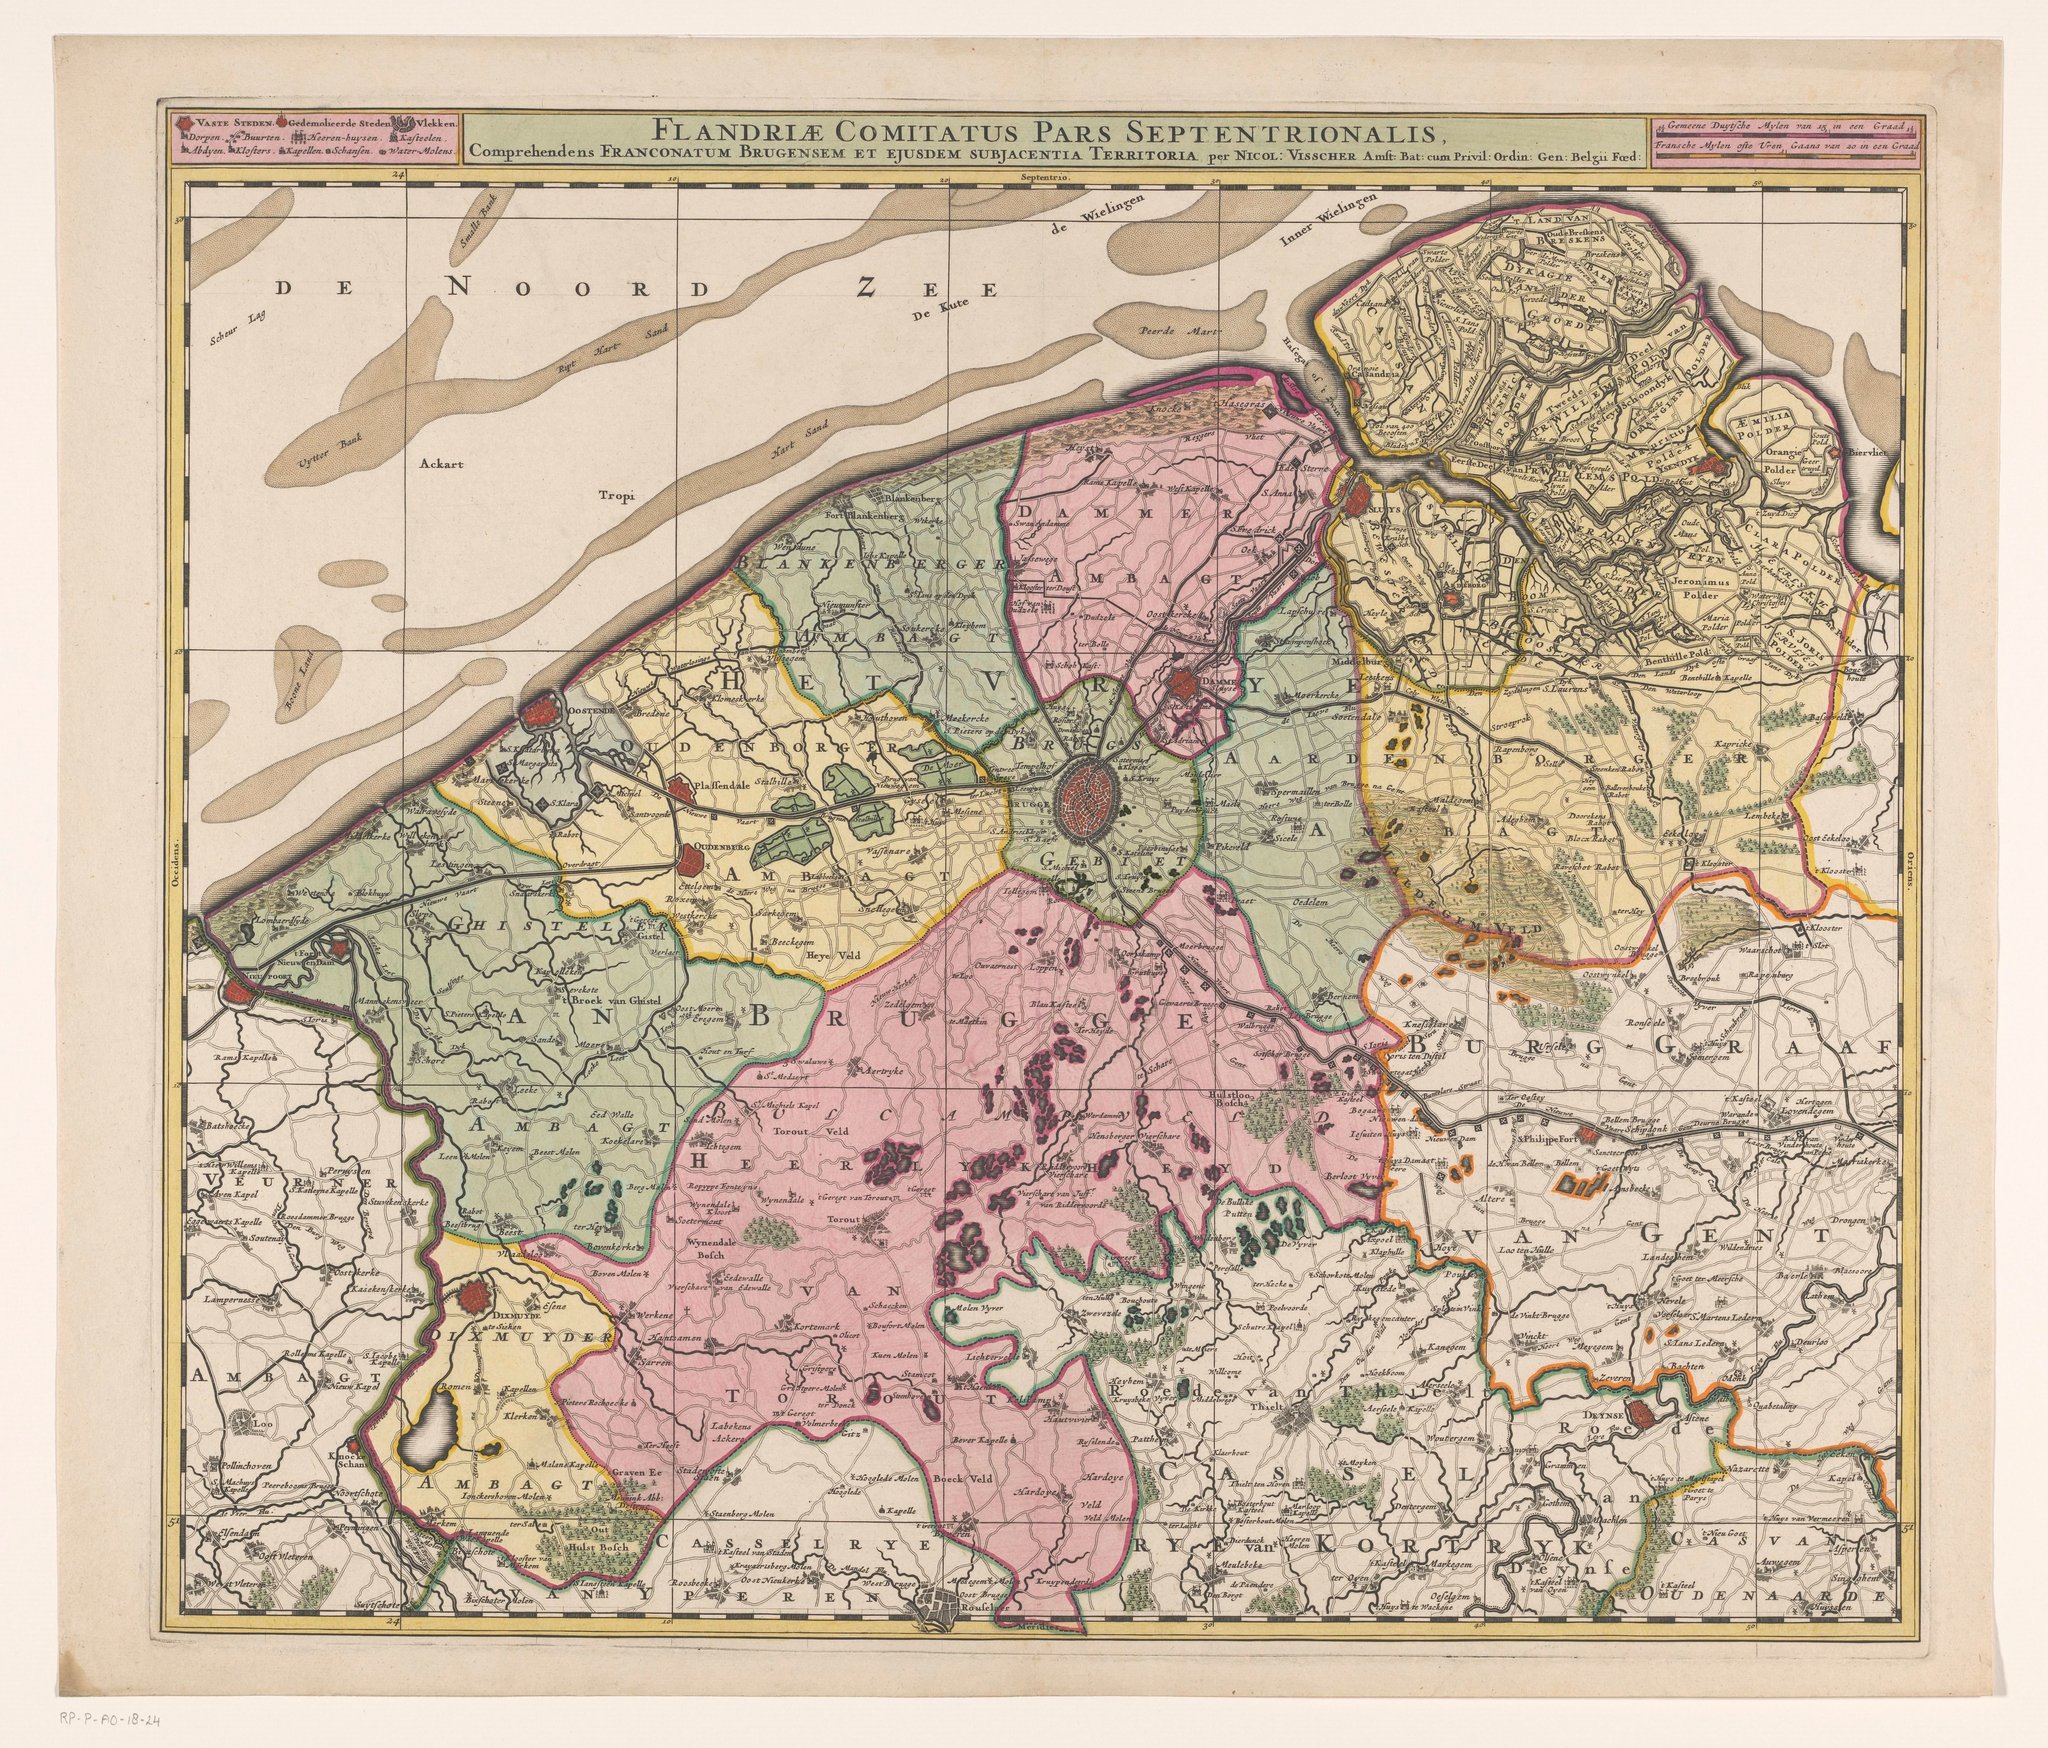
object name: map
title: Kaart van het noordelijk deel van het graafschap Vlaanderen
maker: Anonymous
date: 1677-1720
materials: paper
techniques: engraving, etching, hand coloring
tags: maps of separate countries or regions, bruges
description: Kaart van het noordelijk deel van het graafschap Vlaanderen. In een balk boven de kaart, in het midden, de titel. Links hiervan een legenda. Rechts van de titel twee schaalstokken: 1 1/2 Gemeene Duytsche Mijlen van 15 in een Graad / 2 Fransche Mylen ofte Uren Gaans van 20 in een Graad. De kaart is voorzien van een coördinaten-net en een gradenverdeling.